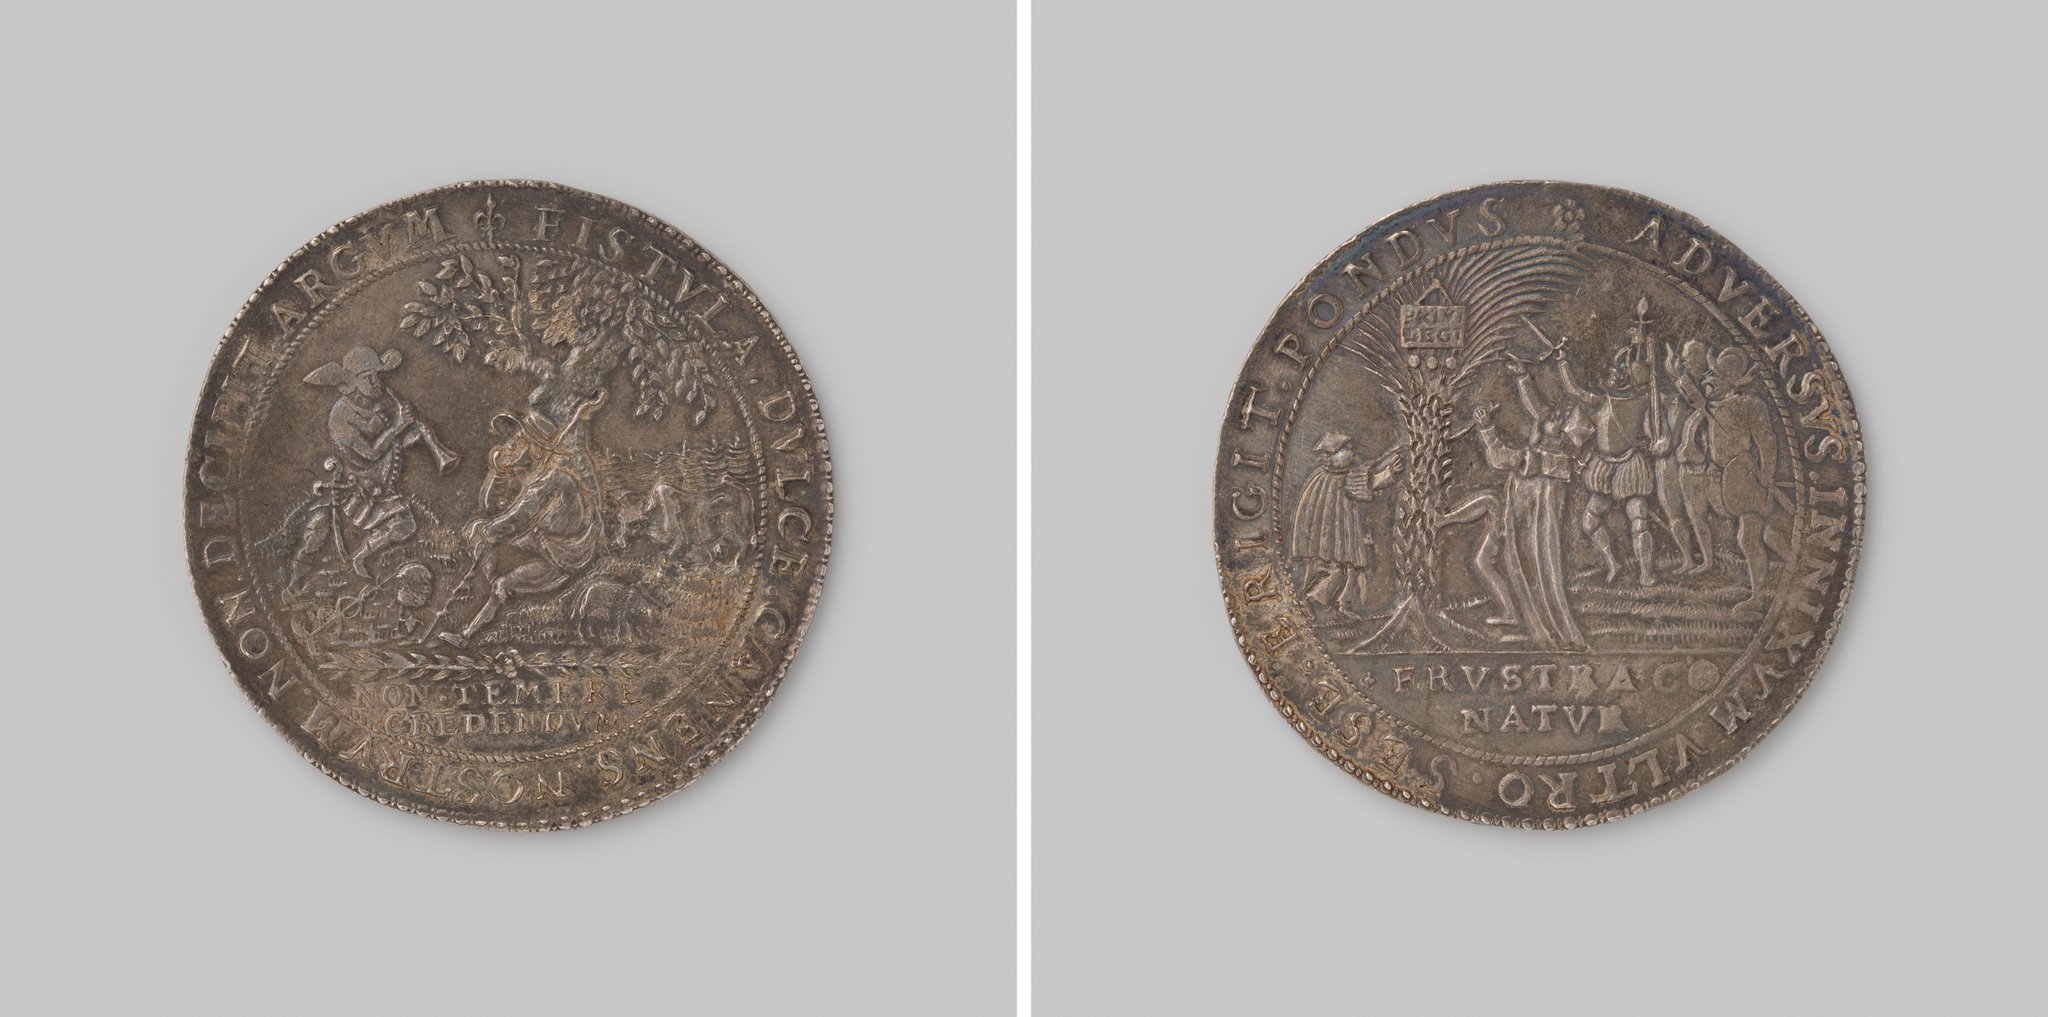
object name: history medal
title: Weigering van de Staten Generaal om over vrede te onderhandelen 1592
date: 1592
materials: silver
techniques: striking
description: Zilveren penning, op de voorzijde Mercurius die Argus, de bewaker van Io, in slaap speelt, met omschrift en afsnedetekst, op de keerzijde een palm met een bord PRIVILEGI door soldaten en geestelijken belaagd, met omschrift en afsnedetekst